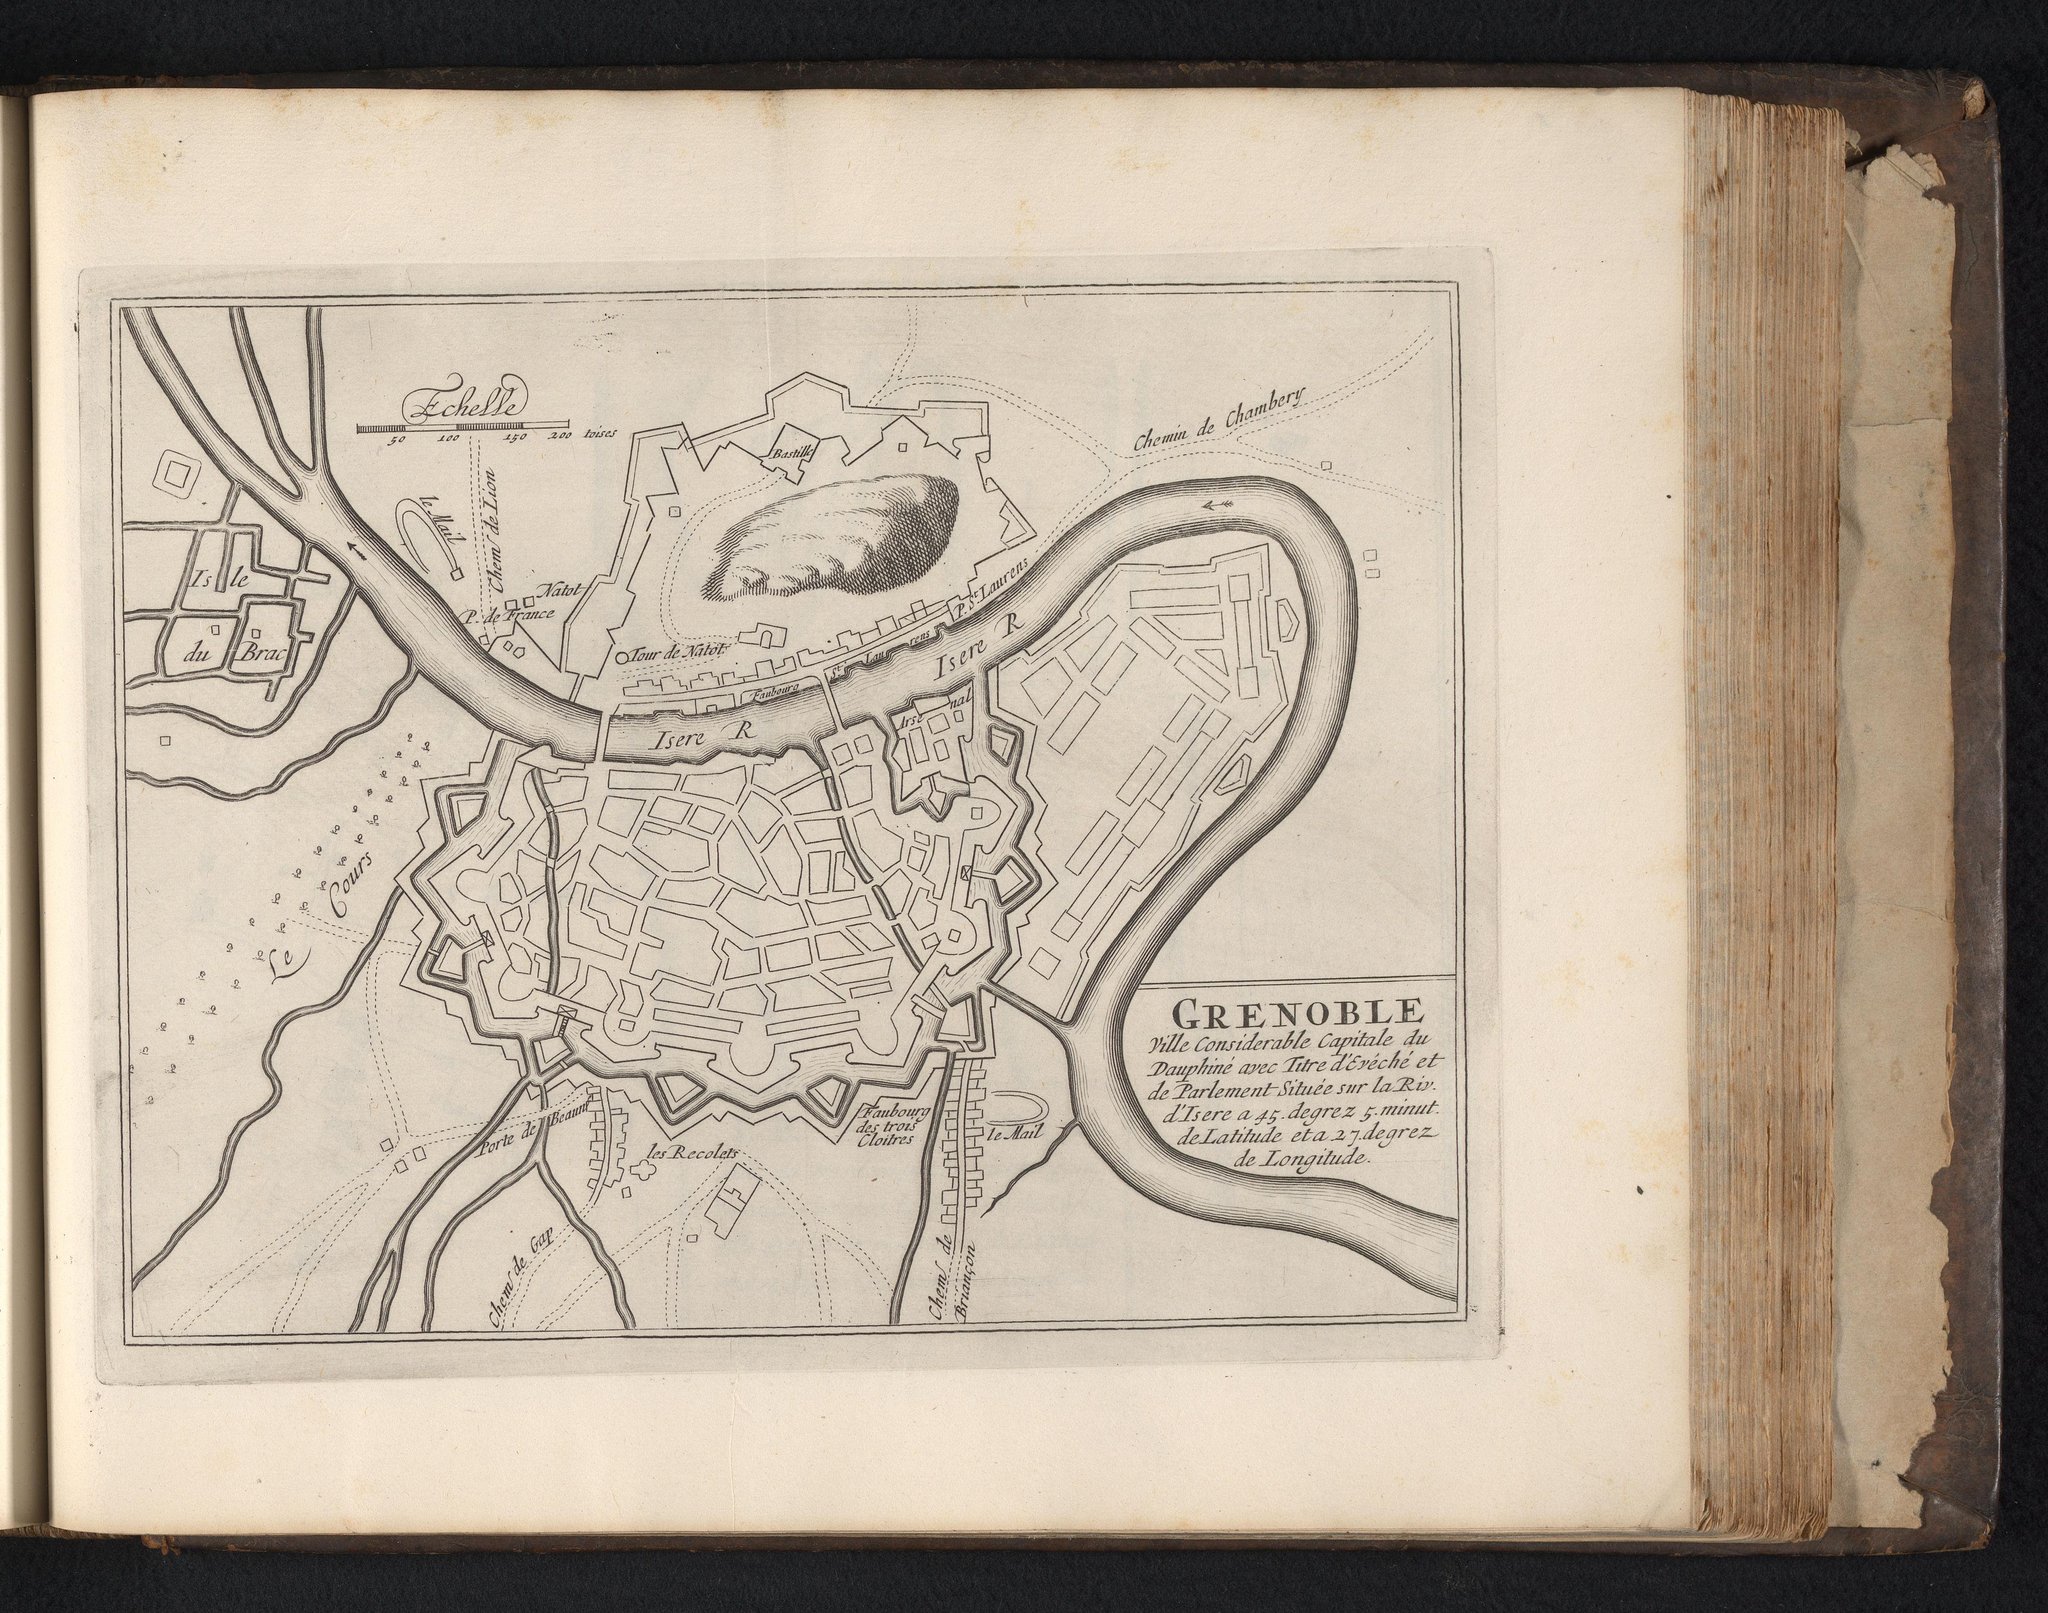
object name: map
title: Les forces de l'Europe, ou description des principales villes, avec leurs fortifications : dessignées par les meilleurs ingenieurs, particulierement celles (...) de la France, dont les plans ont esté levez par M. de Vauban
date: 1695-1697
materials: paper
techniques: etching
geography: france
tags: fortress, maps of cities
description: Plattegrond van de versterkingen om de Franse stad Grenoble. Onderdeel van het achtste deel (1697) van het prentwerk waarin gebundeld zijn de acht delen van Les forces de l'Europe uitgegeven tussen 1693-1697. Het prentwerk bestaat uit 175 platen met plannen (afkomstig van Sébastien Le Prestre, Seigneur de Vauban) van vermaarde sterke steden en vestingen in de Negenjarige Oorlog. Titel en opschriften in het Frans.